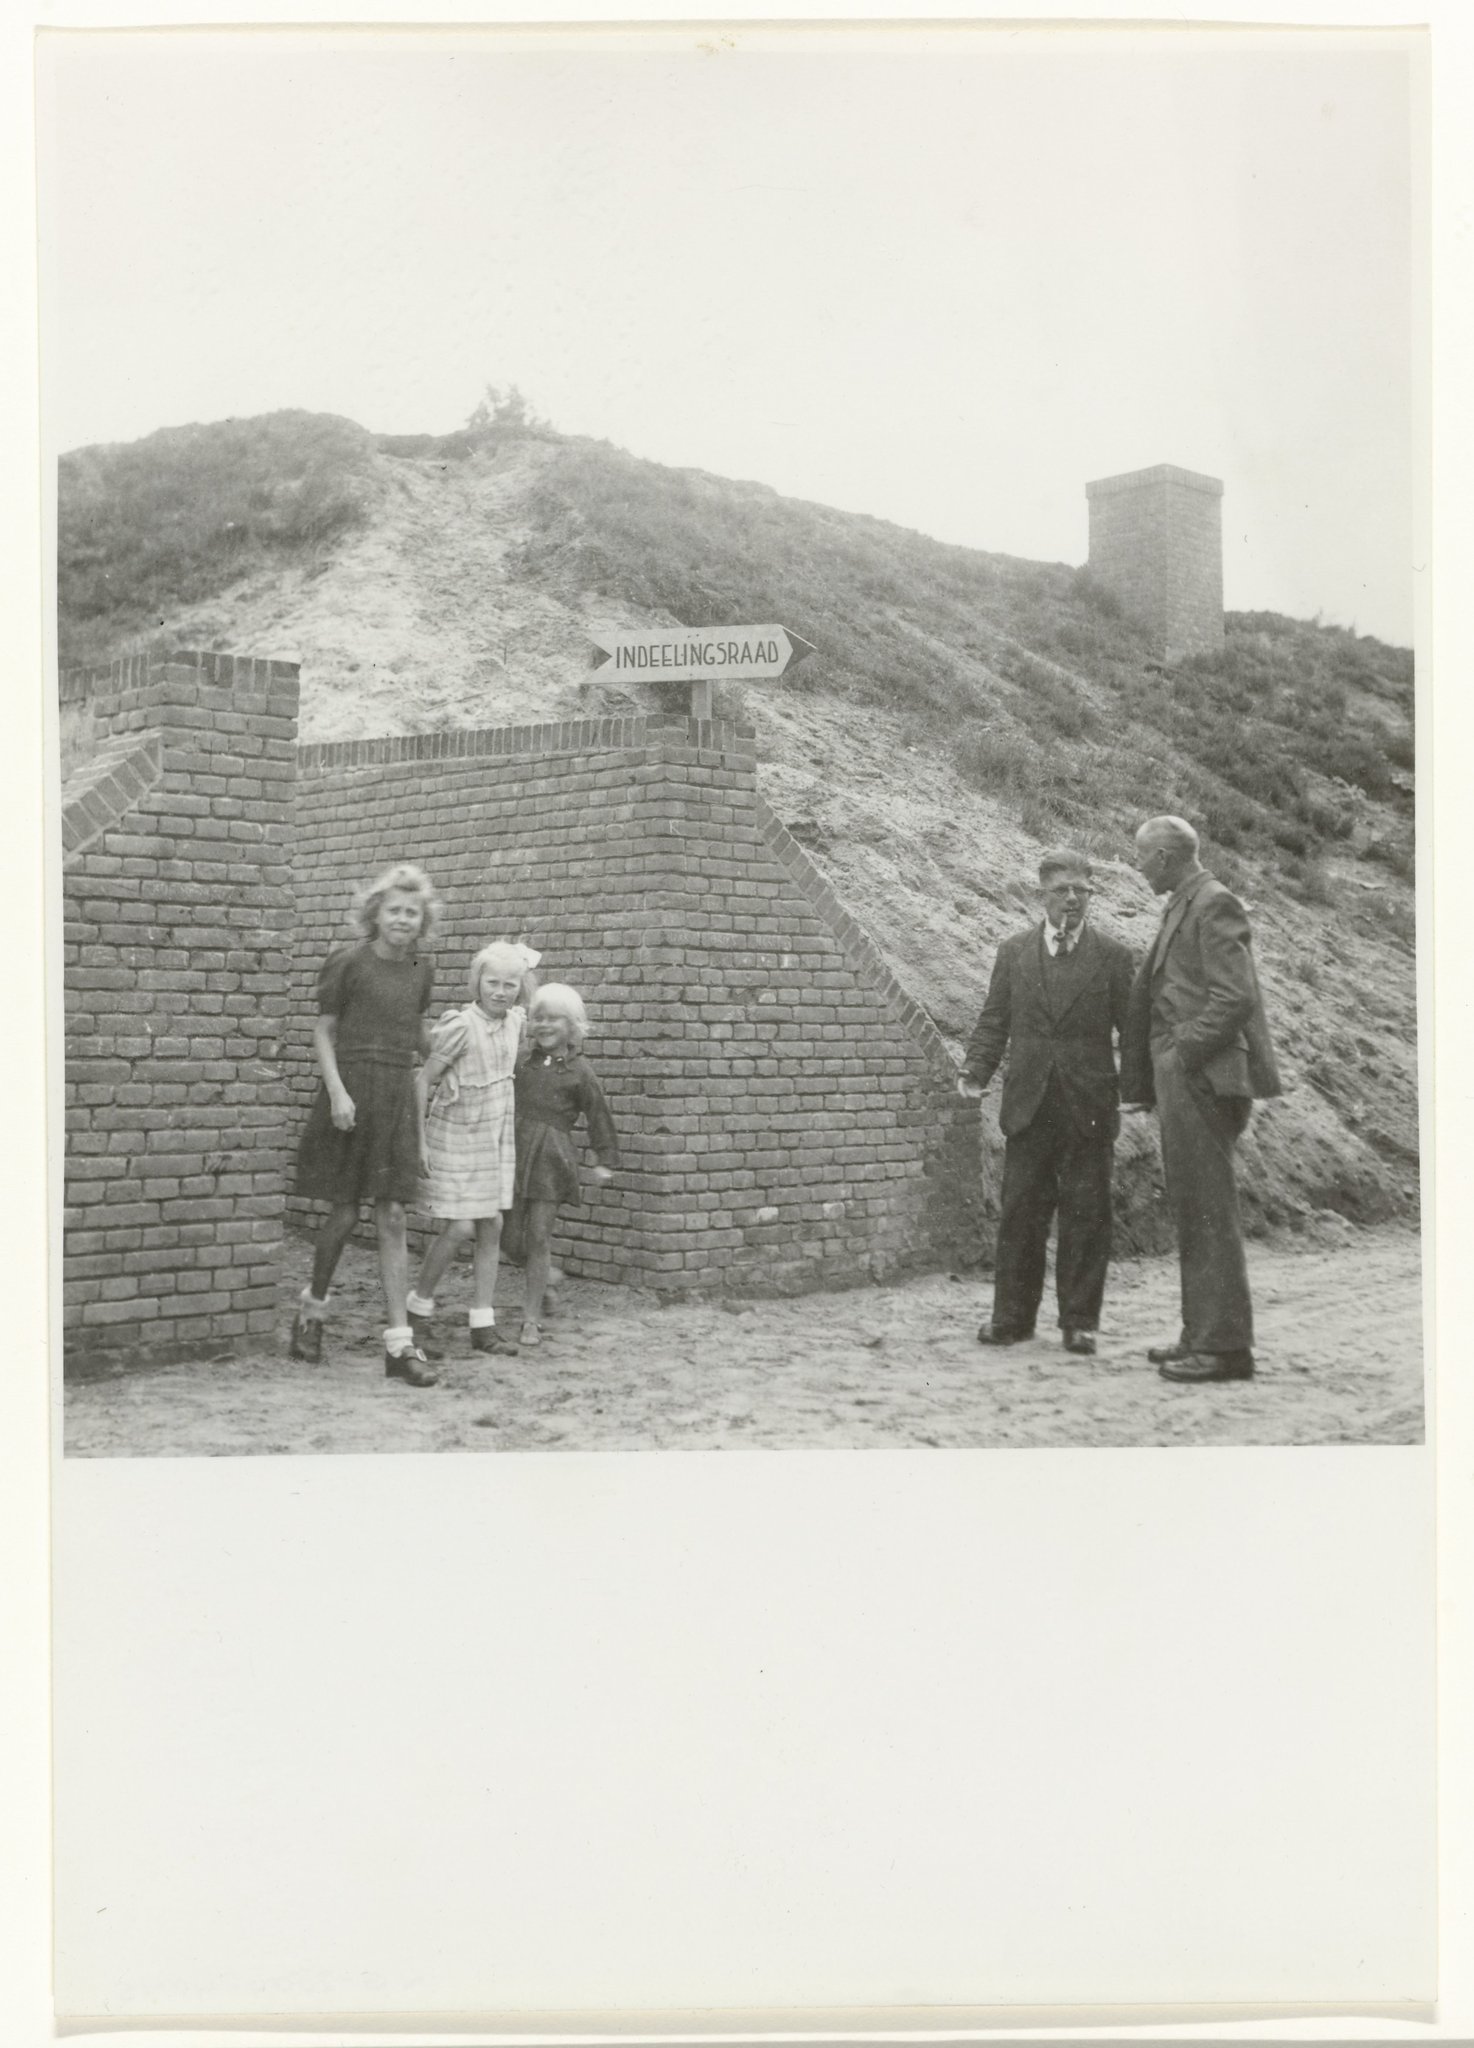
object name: documentary photograph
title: Kinderen bij een "bunker"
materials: photographic support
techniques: photography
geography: netherlands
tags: netherlands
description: Drie kinderen komen uit de ingang van een bakstenen toegang tot een bunker welke onder een zandheuvel is verborgen. Op de ingang staat een bord: Indeelingsraad. Rechts staan twee mannen. Uit de zandheuvel steekt rechts een schoorsteen.